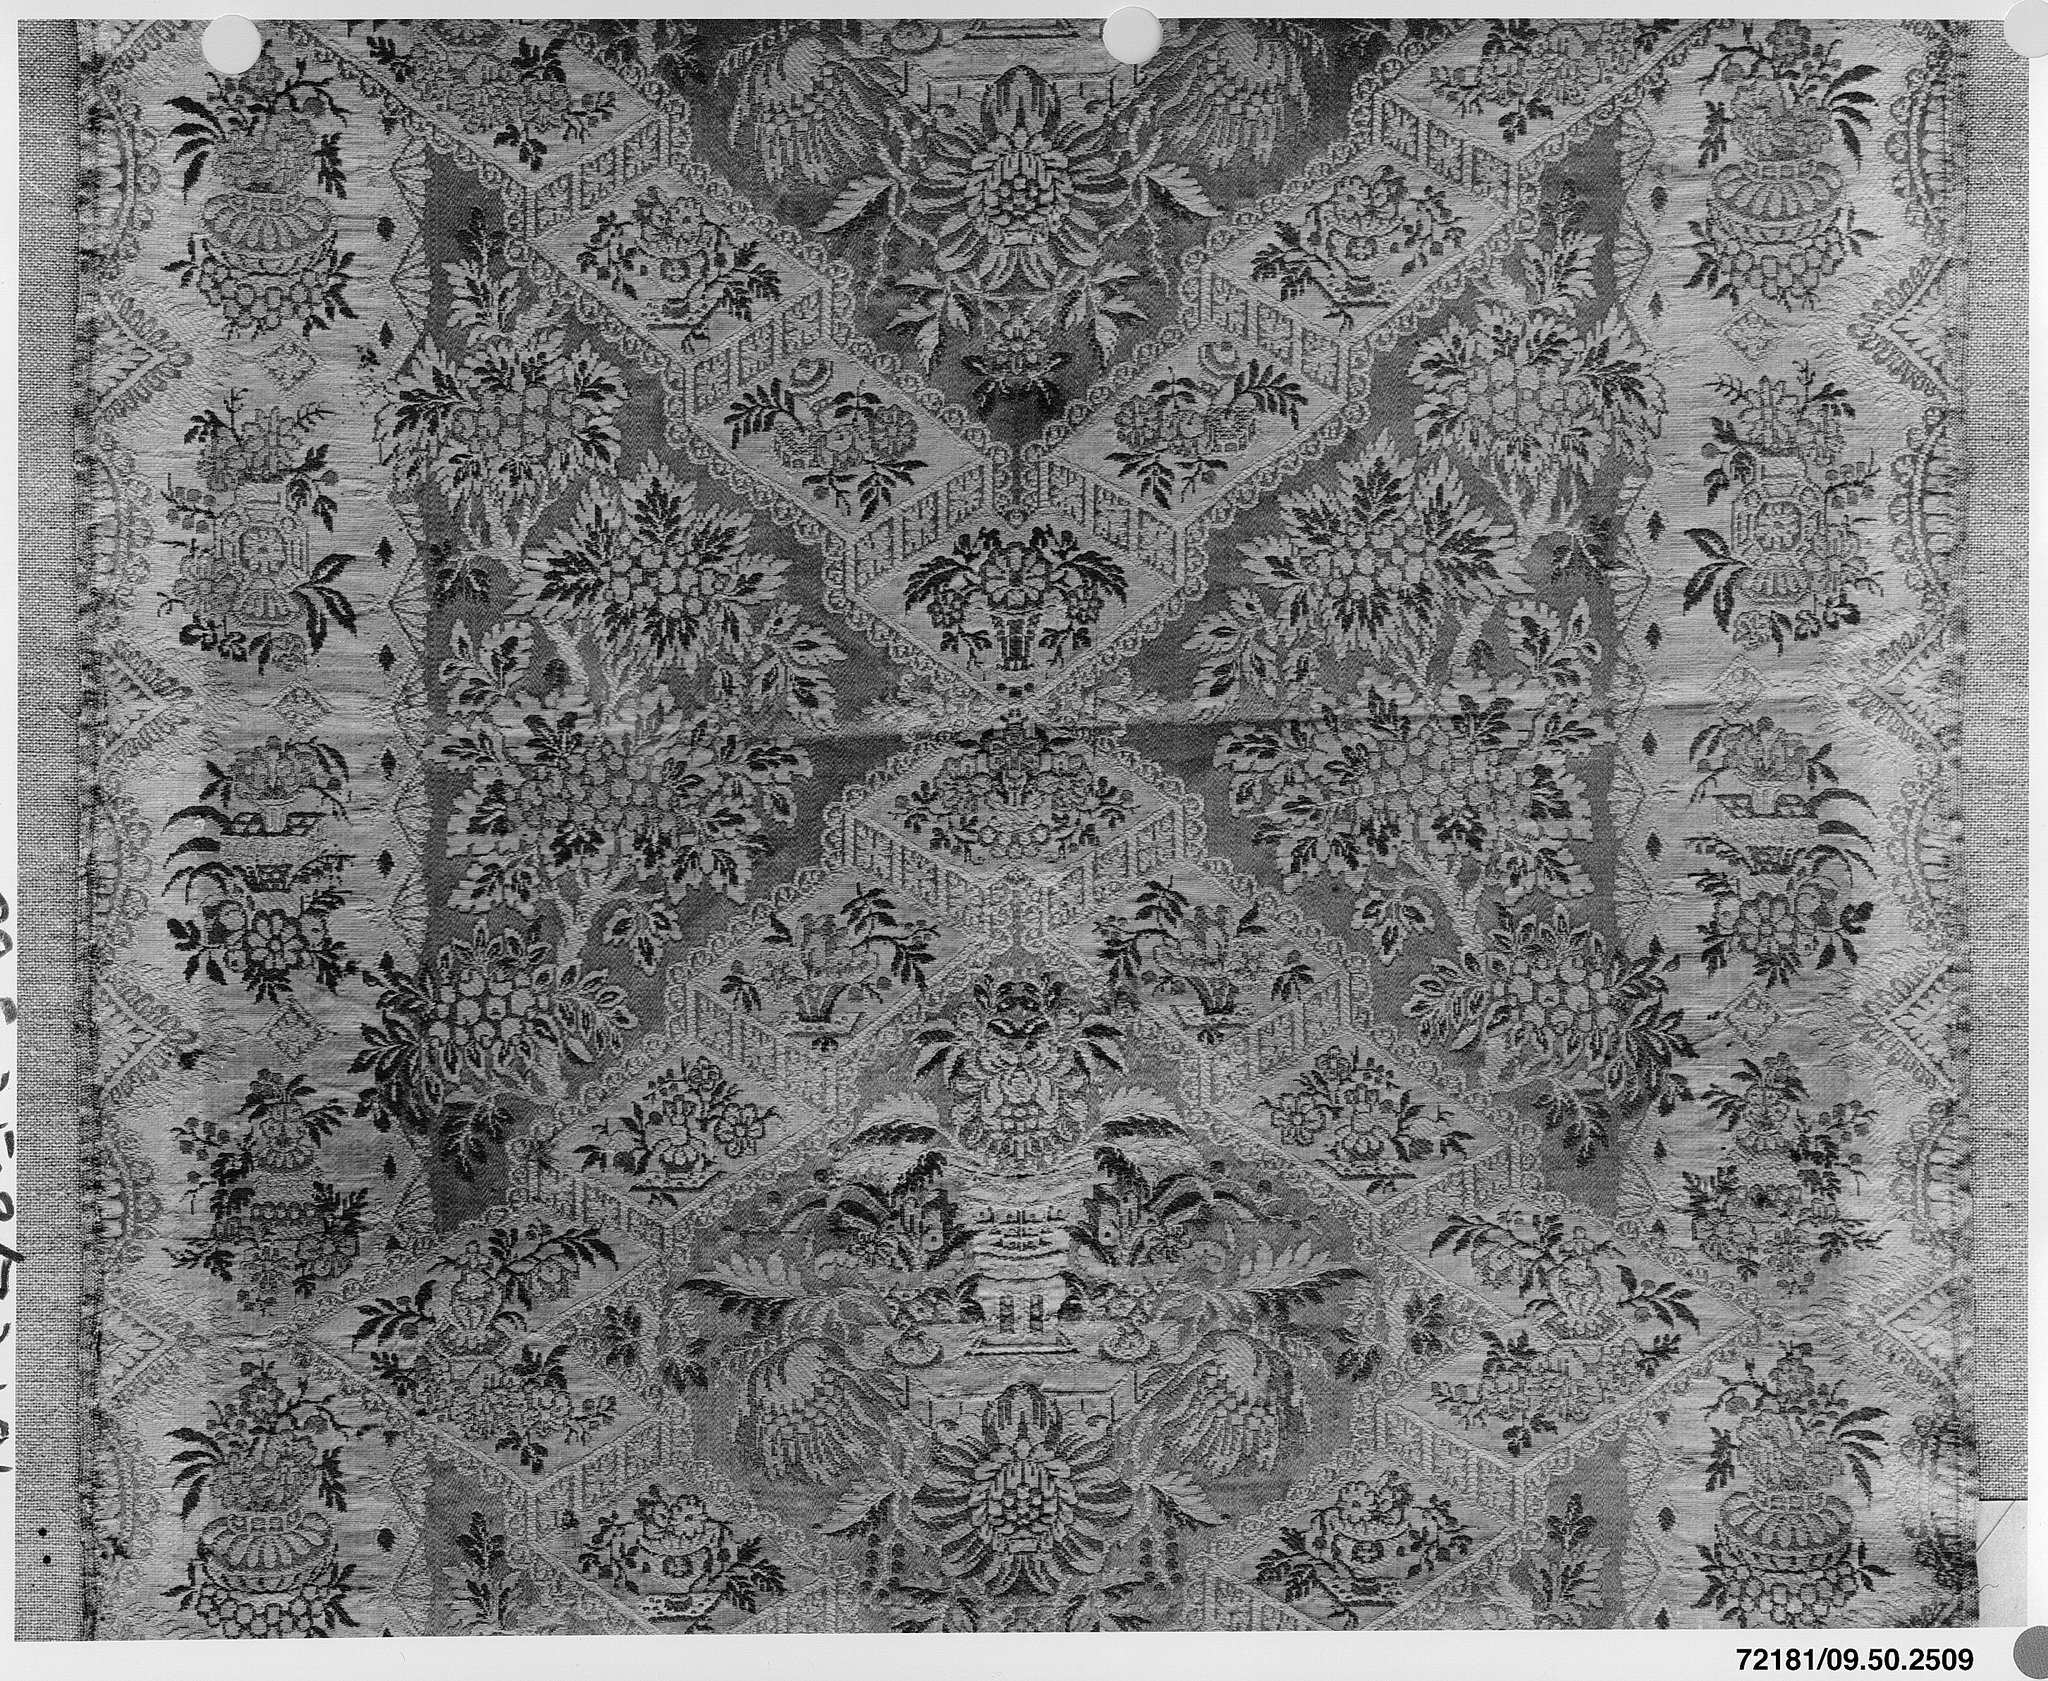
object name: piece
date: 1725-1730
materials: silk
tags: flowers,leaves,trees